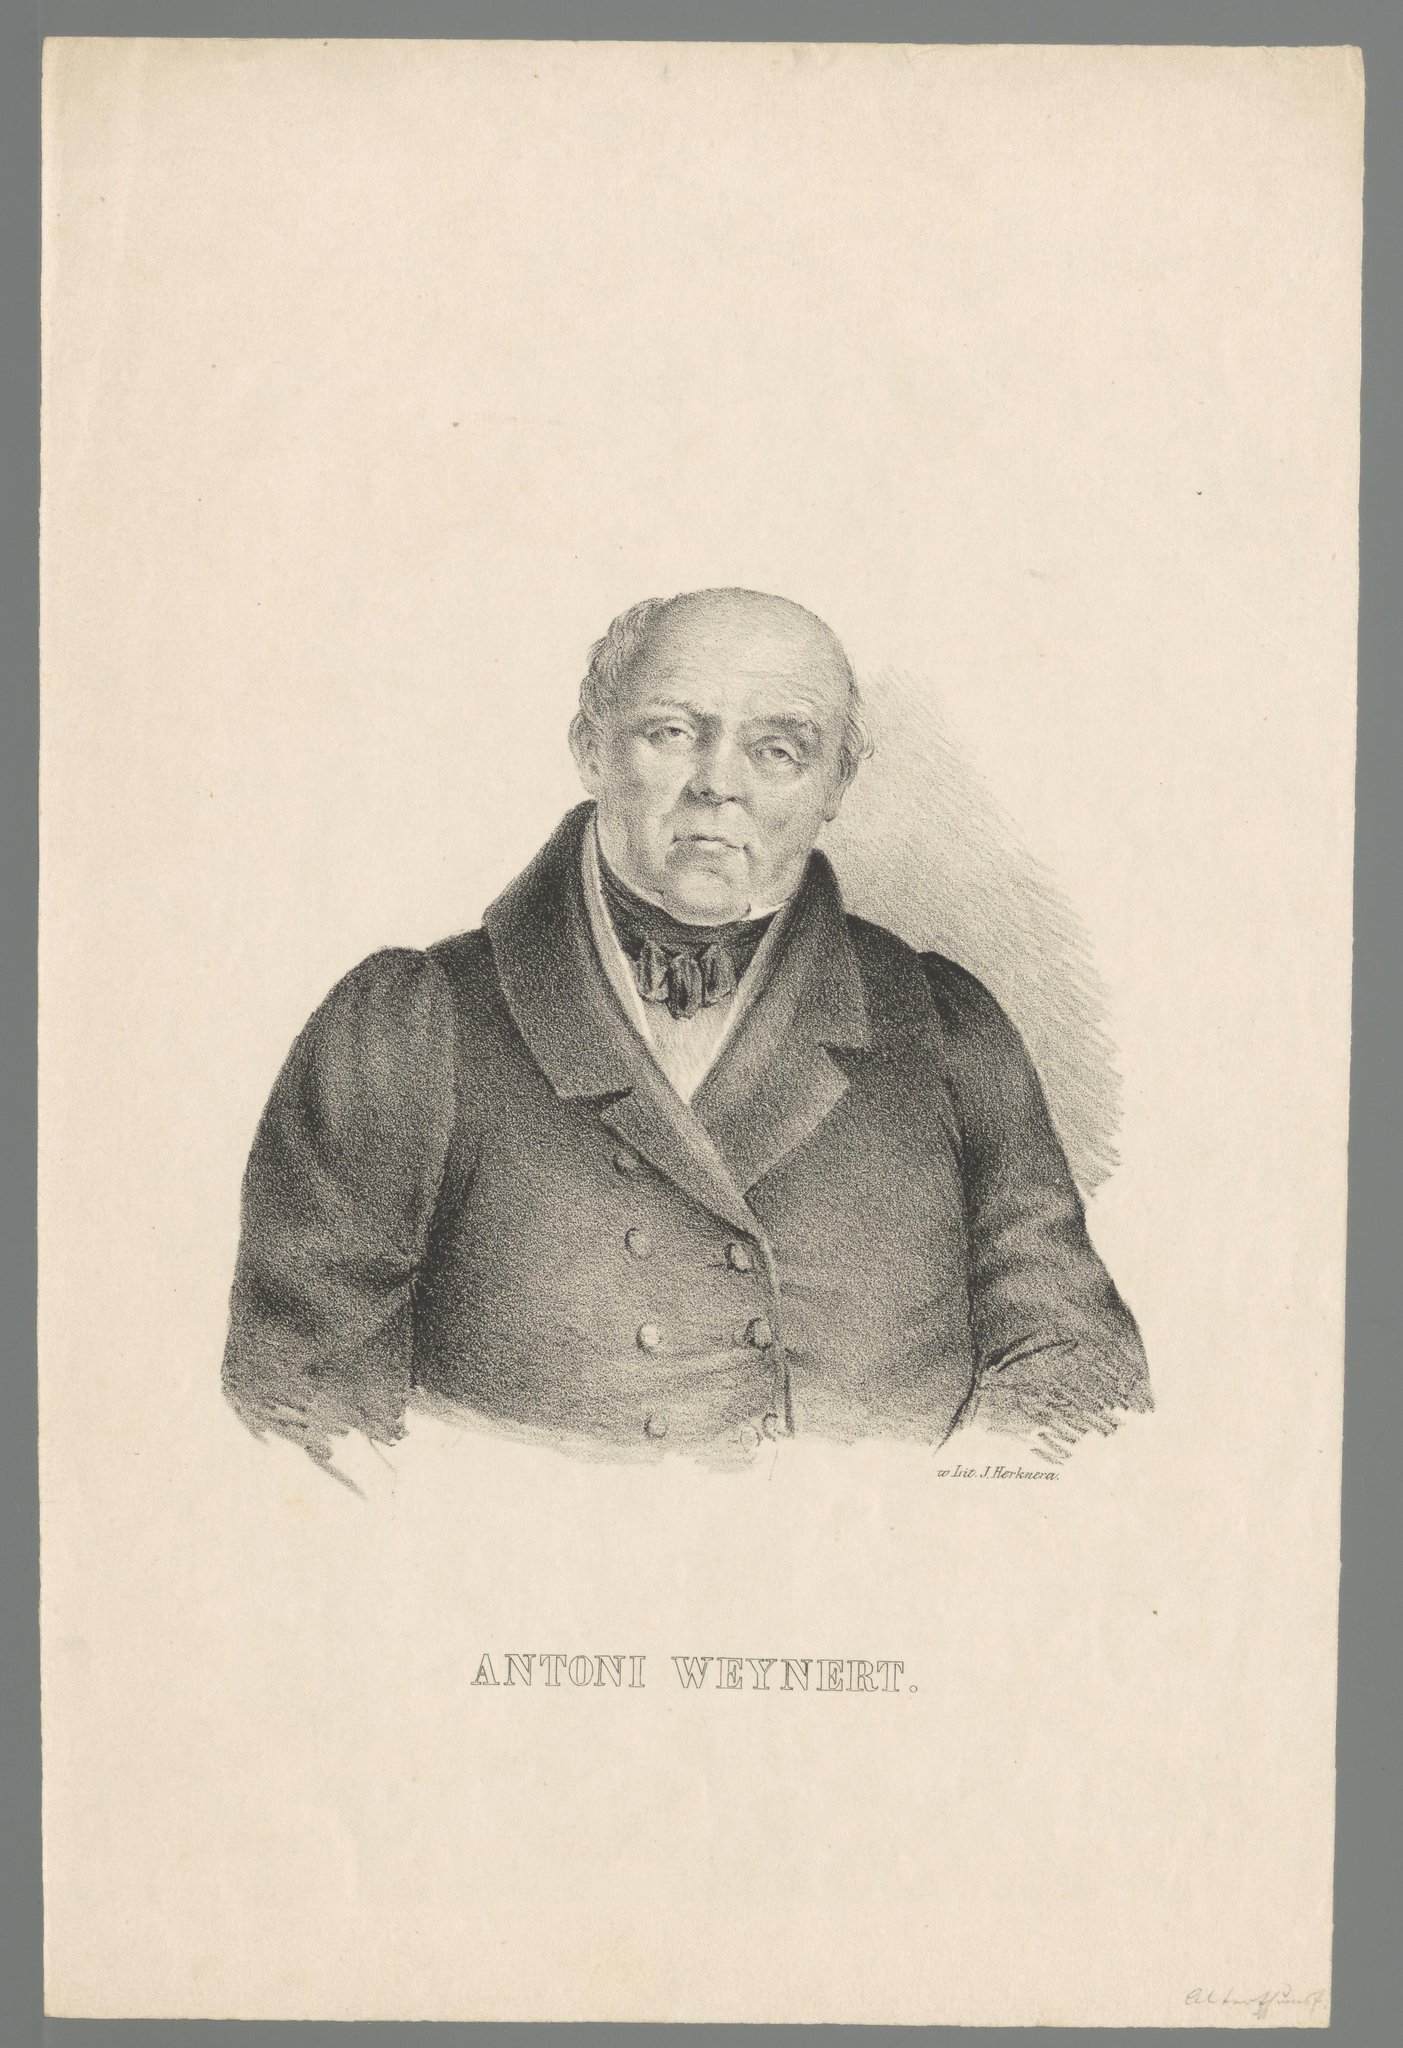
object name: print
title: Portret van Antoni Weynert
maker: j. herknera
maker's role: print maker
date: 1820-1860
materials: paper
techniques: lithograph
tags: historical persons not known by name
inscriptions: collector's mark: Lugt 2228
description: Portret van een verder onbekende man met de naam Antoni Weynert.